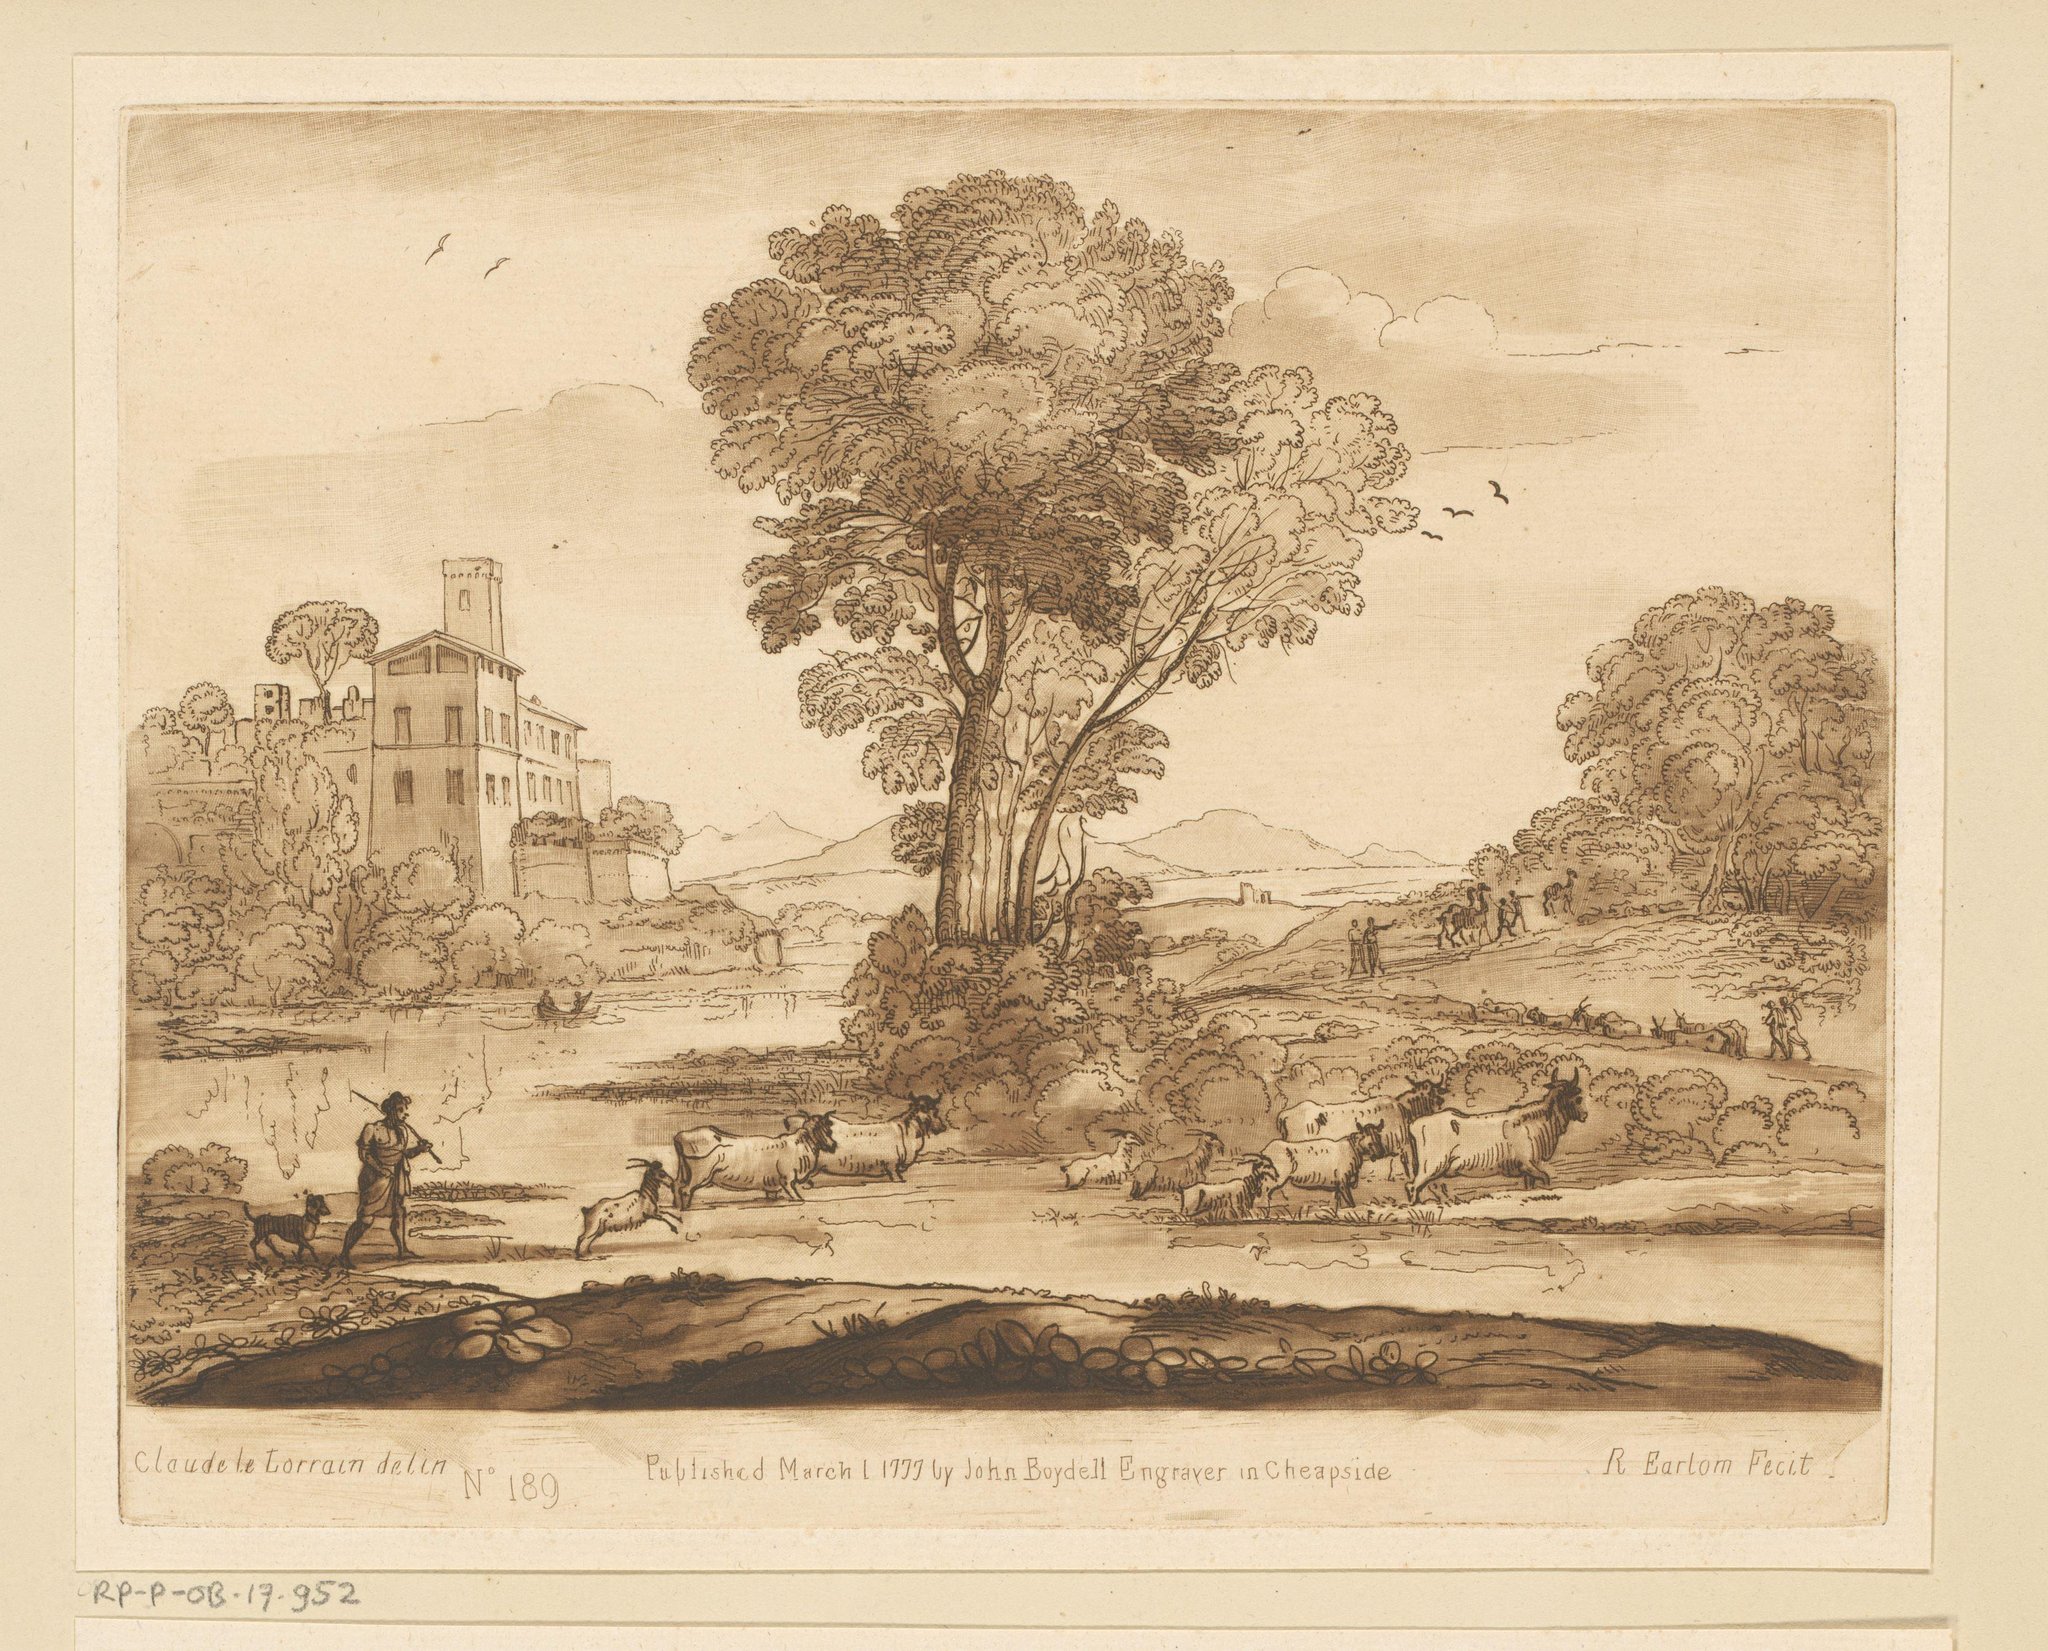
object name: print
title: Liber Veritatis. Or a Collection of Two Hundred Prints, after the original designs of Claude le Lorrain (...)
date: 1777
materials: paper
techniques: etching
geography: london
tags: river - hh - ideal landscapes, crossing a river, city-view, and landscape with man-made constructions - ii - ideal landscapes, jacob on the way to canaan with his family, his flocks, camels and all his possessions, cattle driving, cattle driver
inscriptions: date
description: Vanaf 1774 publiceerde John Boydell tweehonderd prenten naar het tekeningenboek Liber Veritatis van Claude Lorrain, in het bezit van de hertogen van Cavendish. Deze prenten werden vanaf 1777 in twee volumes gebundeld uitgegeven.